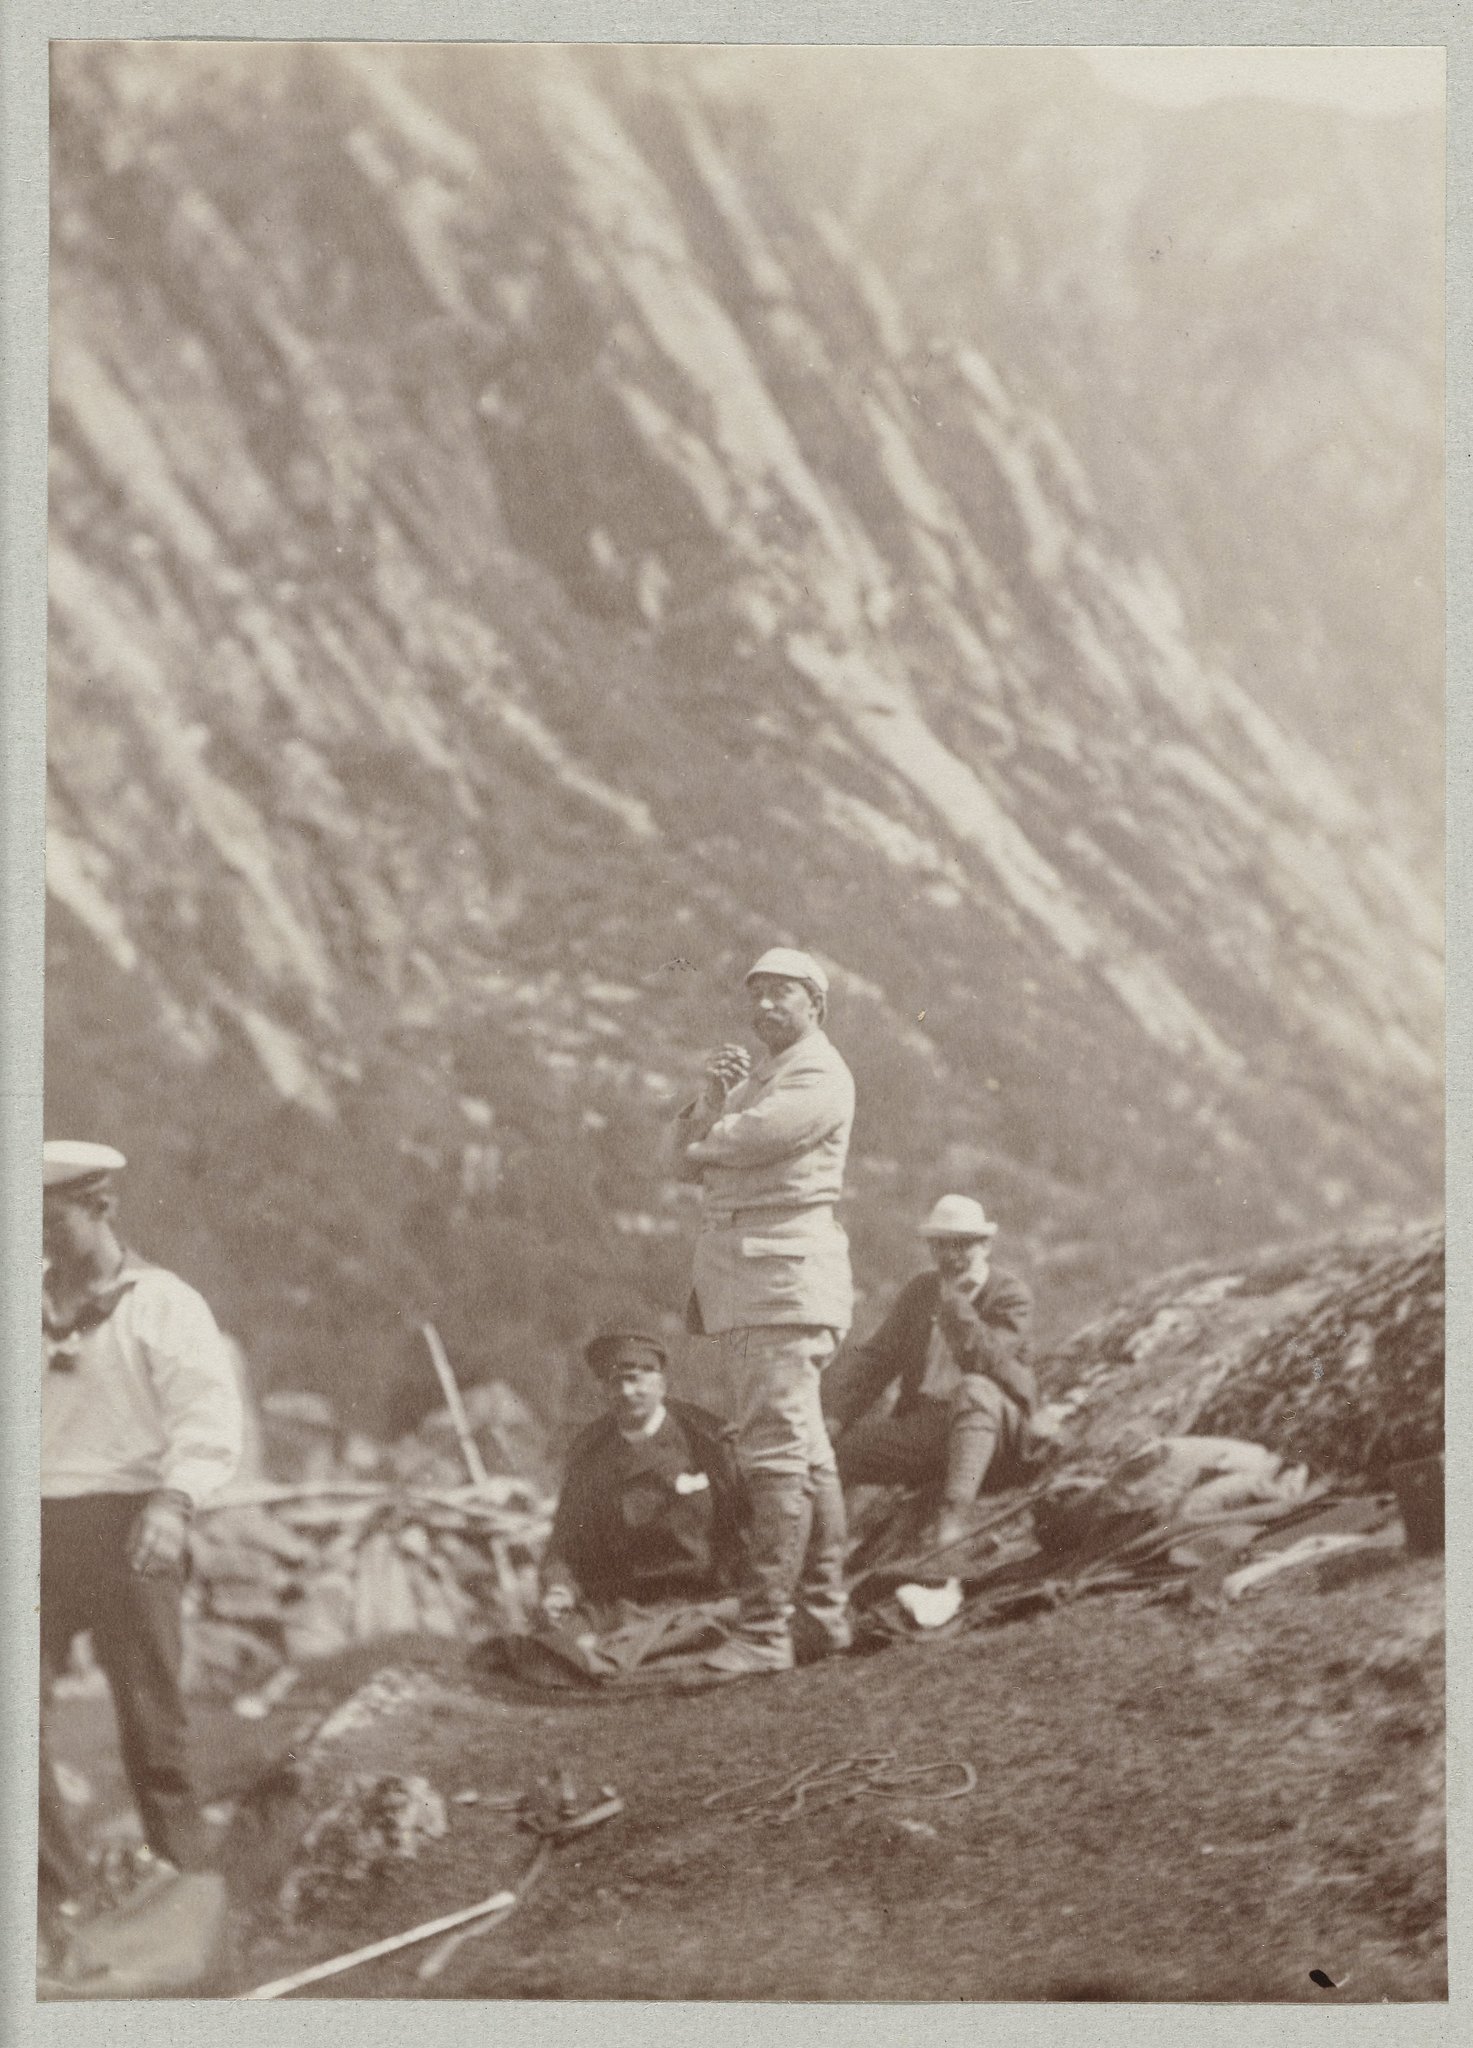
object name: photograph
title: Keizer Wilhelm II en een aantal gasten rusten in het Noorse landschap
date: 1807-1889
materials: cardboard, paper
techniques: albumen print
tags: wilhelm ii (keizer van duitsland), norway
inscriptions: number: ‘6’